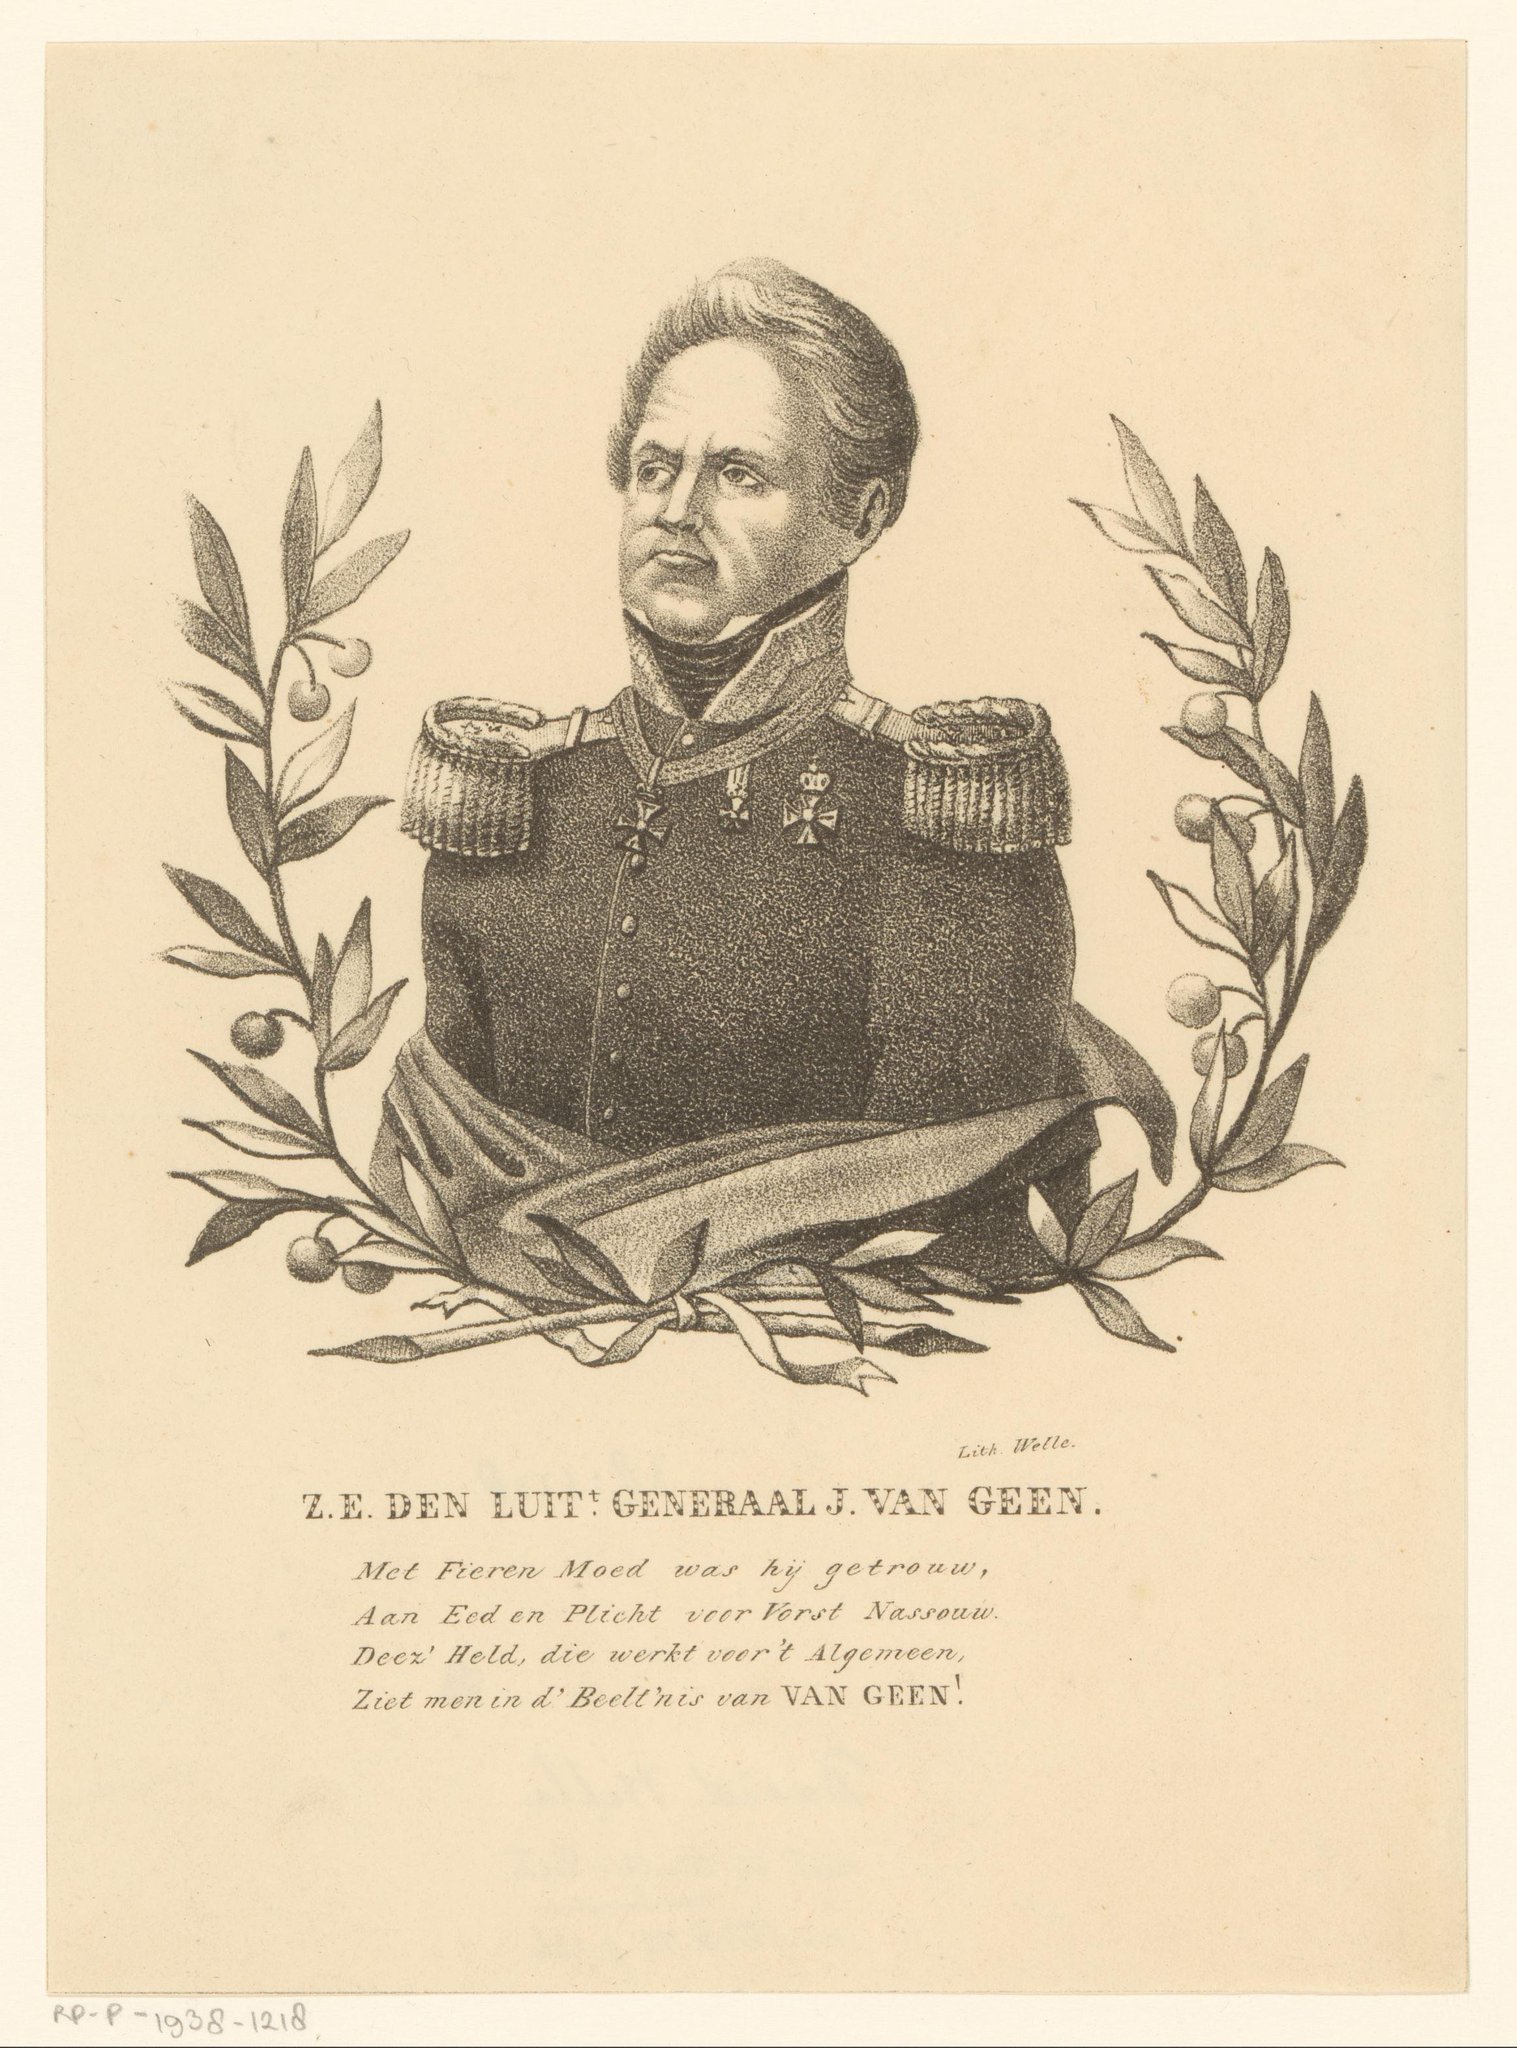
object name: print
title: Portret van Josephus Jacobus van Geen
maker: david welle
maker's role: print maker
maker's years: 1772-1848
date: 1846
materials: paper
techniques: lithograph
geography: rotterdam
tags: ghent, crowning with laurel, historical persons (+ (full) bust portrait)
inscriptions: collector's mark: Lugt 2228, collector's mark: Lugt 2760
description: Rondom de geportretteerde een krans van laurierbladeren. Onder het portret zijn naam en een vierregelig onderschrift.